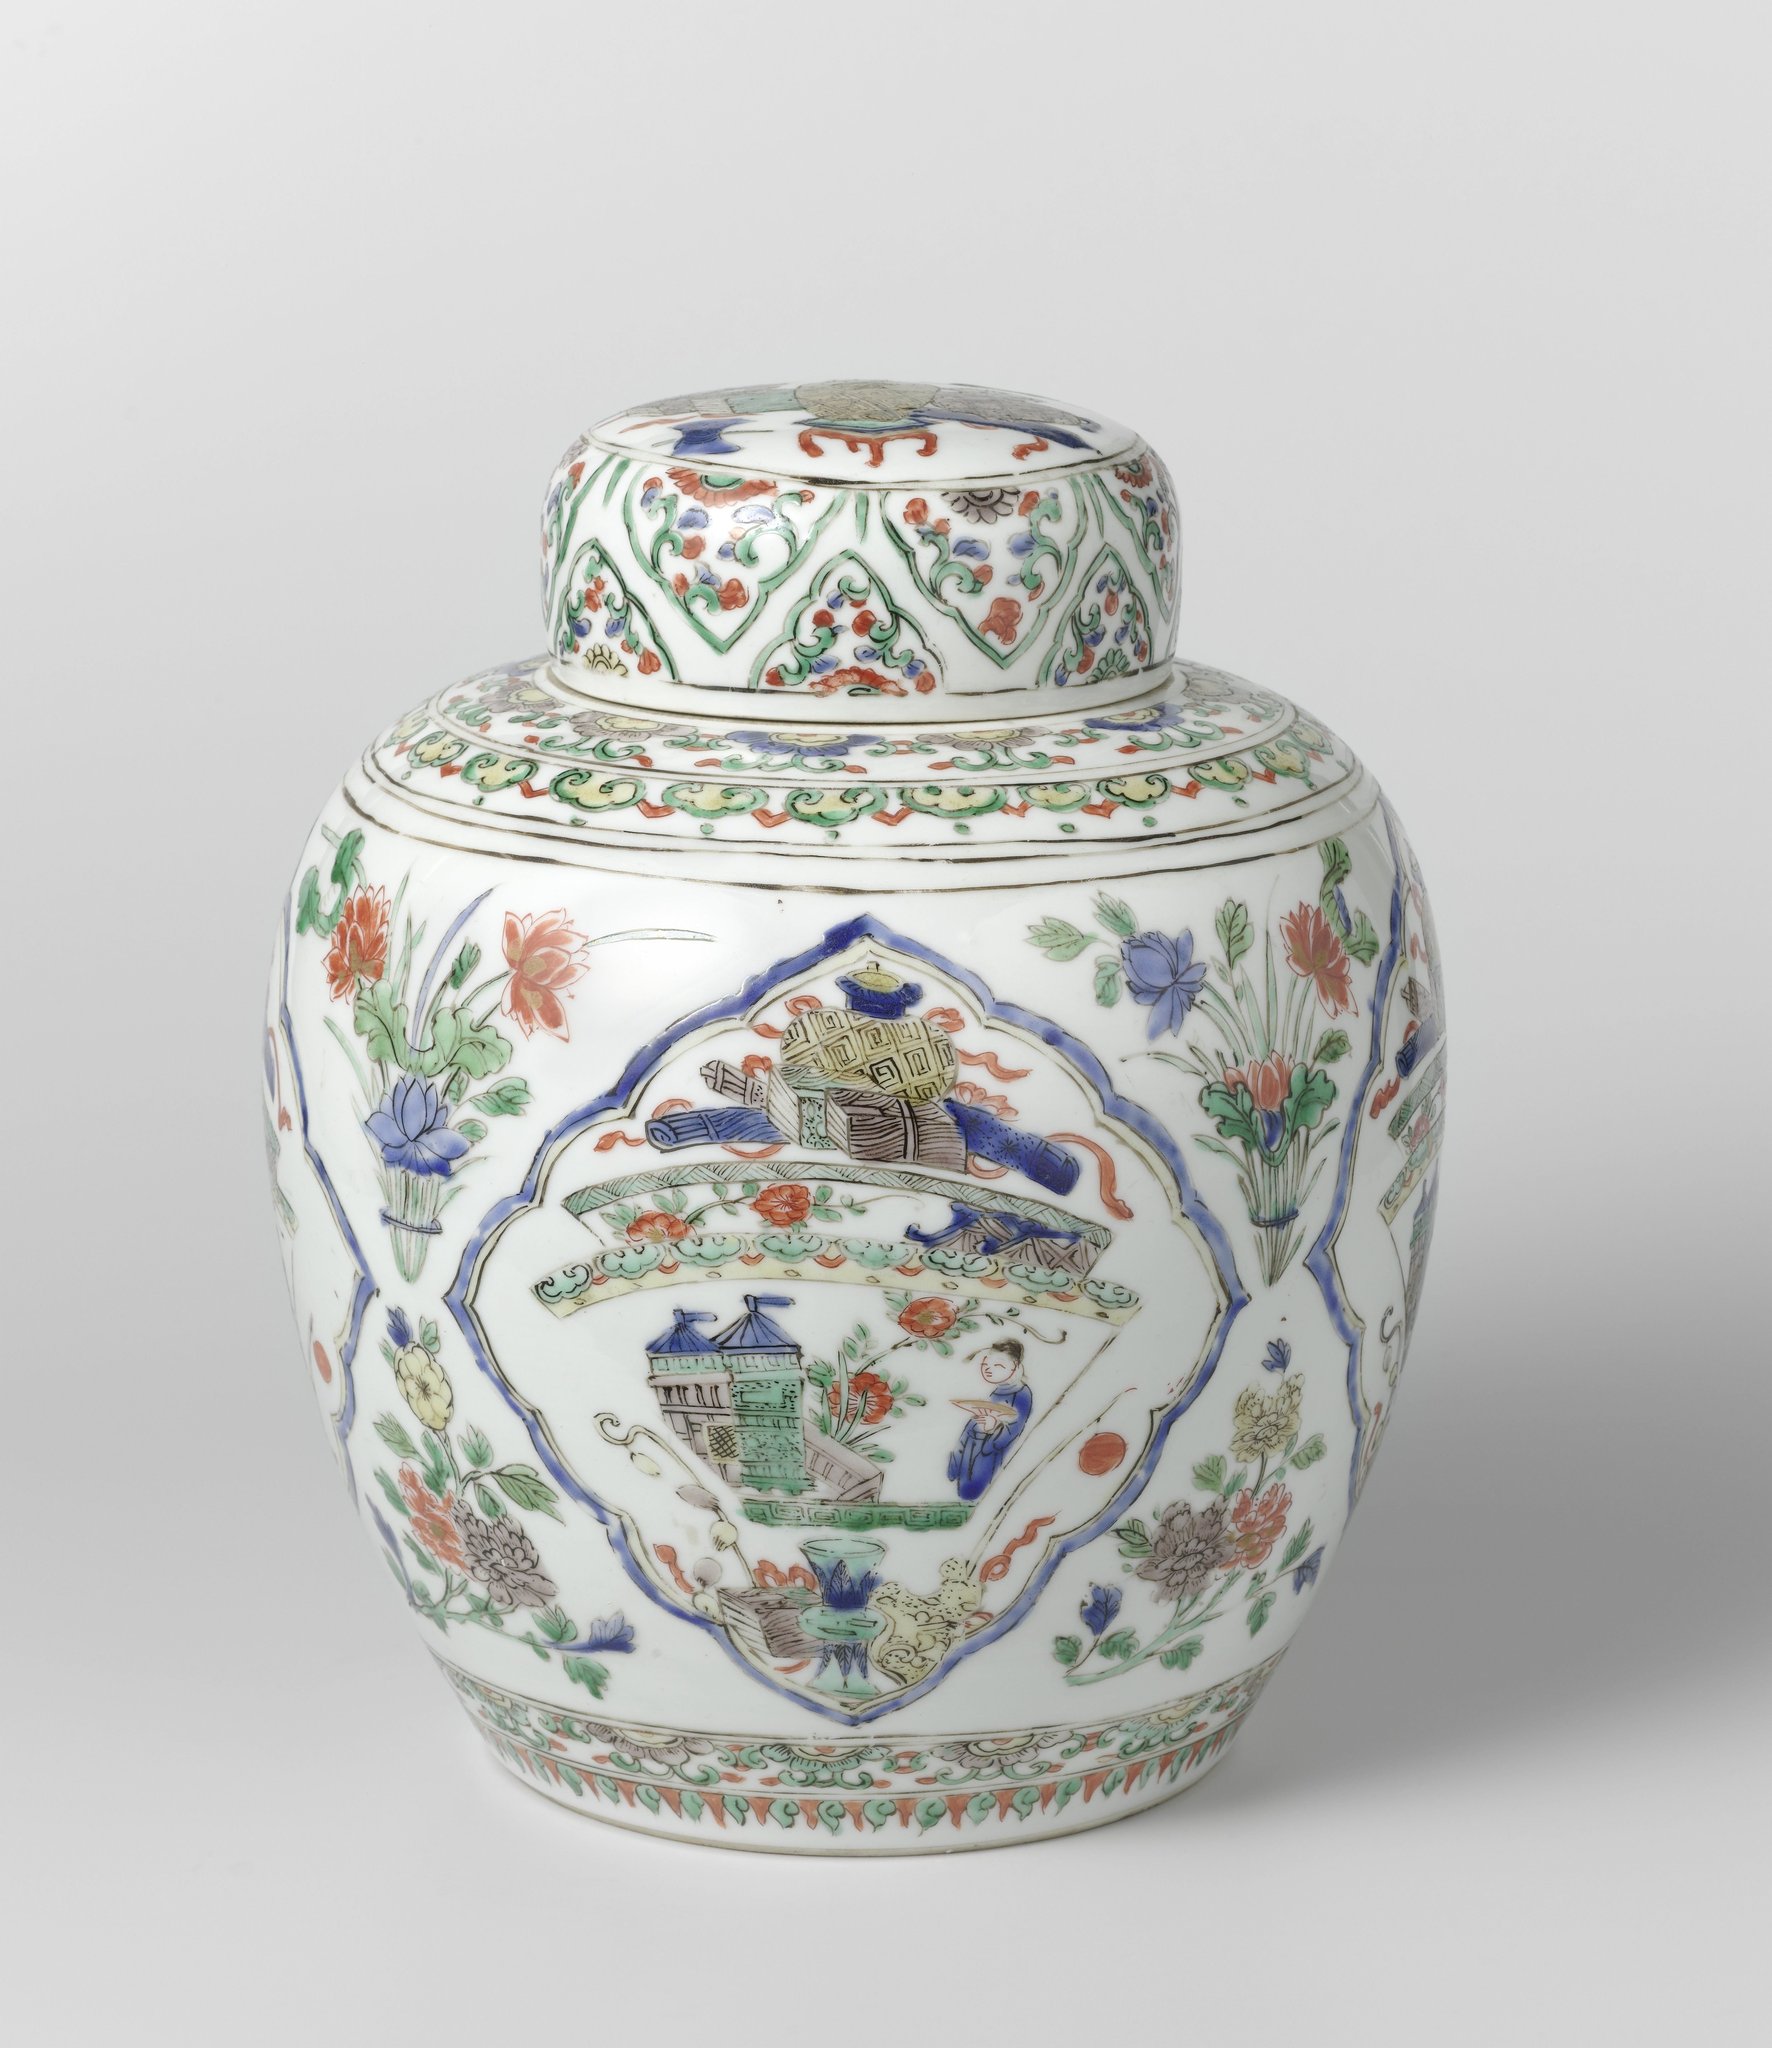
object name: pot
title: Covered, ovoid jar with antiquities and flower sprays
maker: Anonymous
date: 1700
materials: cobalt, glaze, gold, paint, porcelain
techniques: firing, gilding, turning, vitrification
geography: china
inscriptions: mark